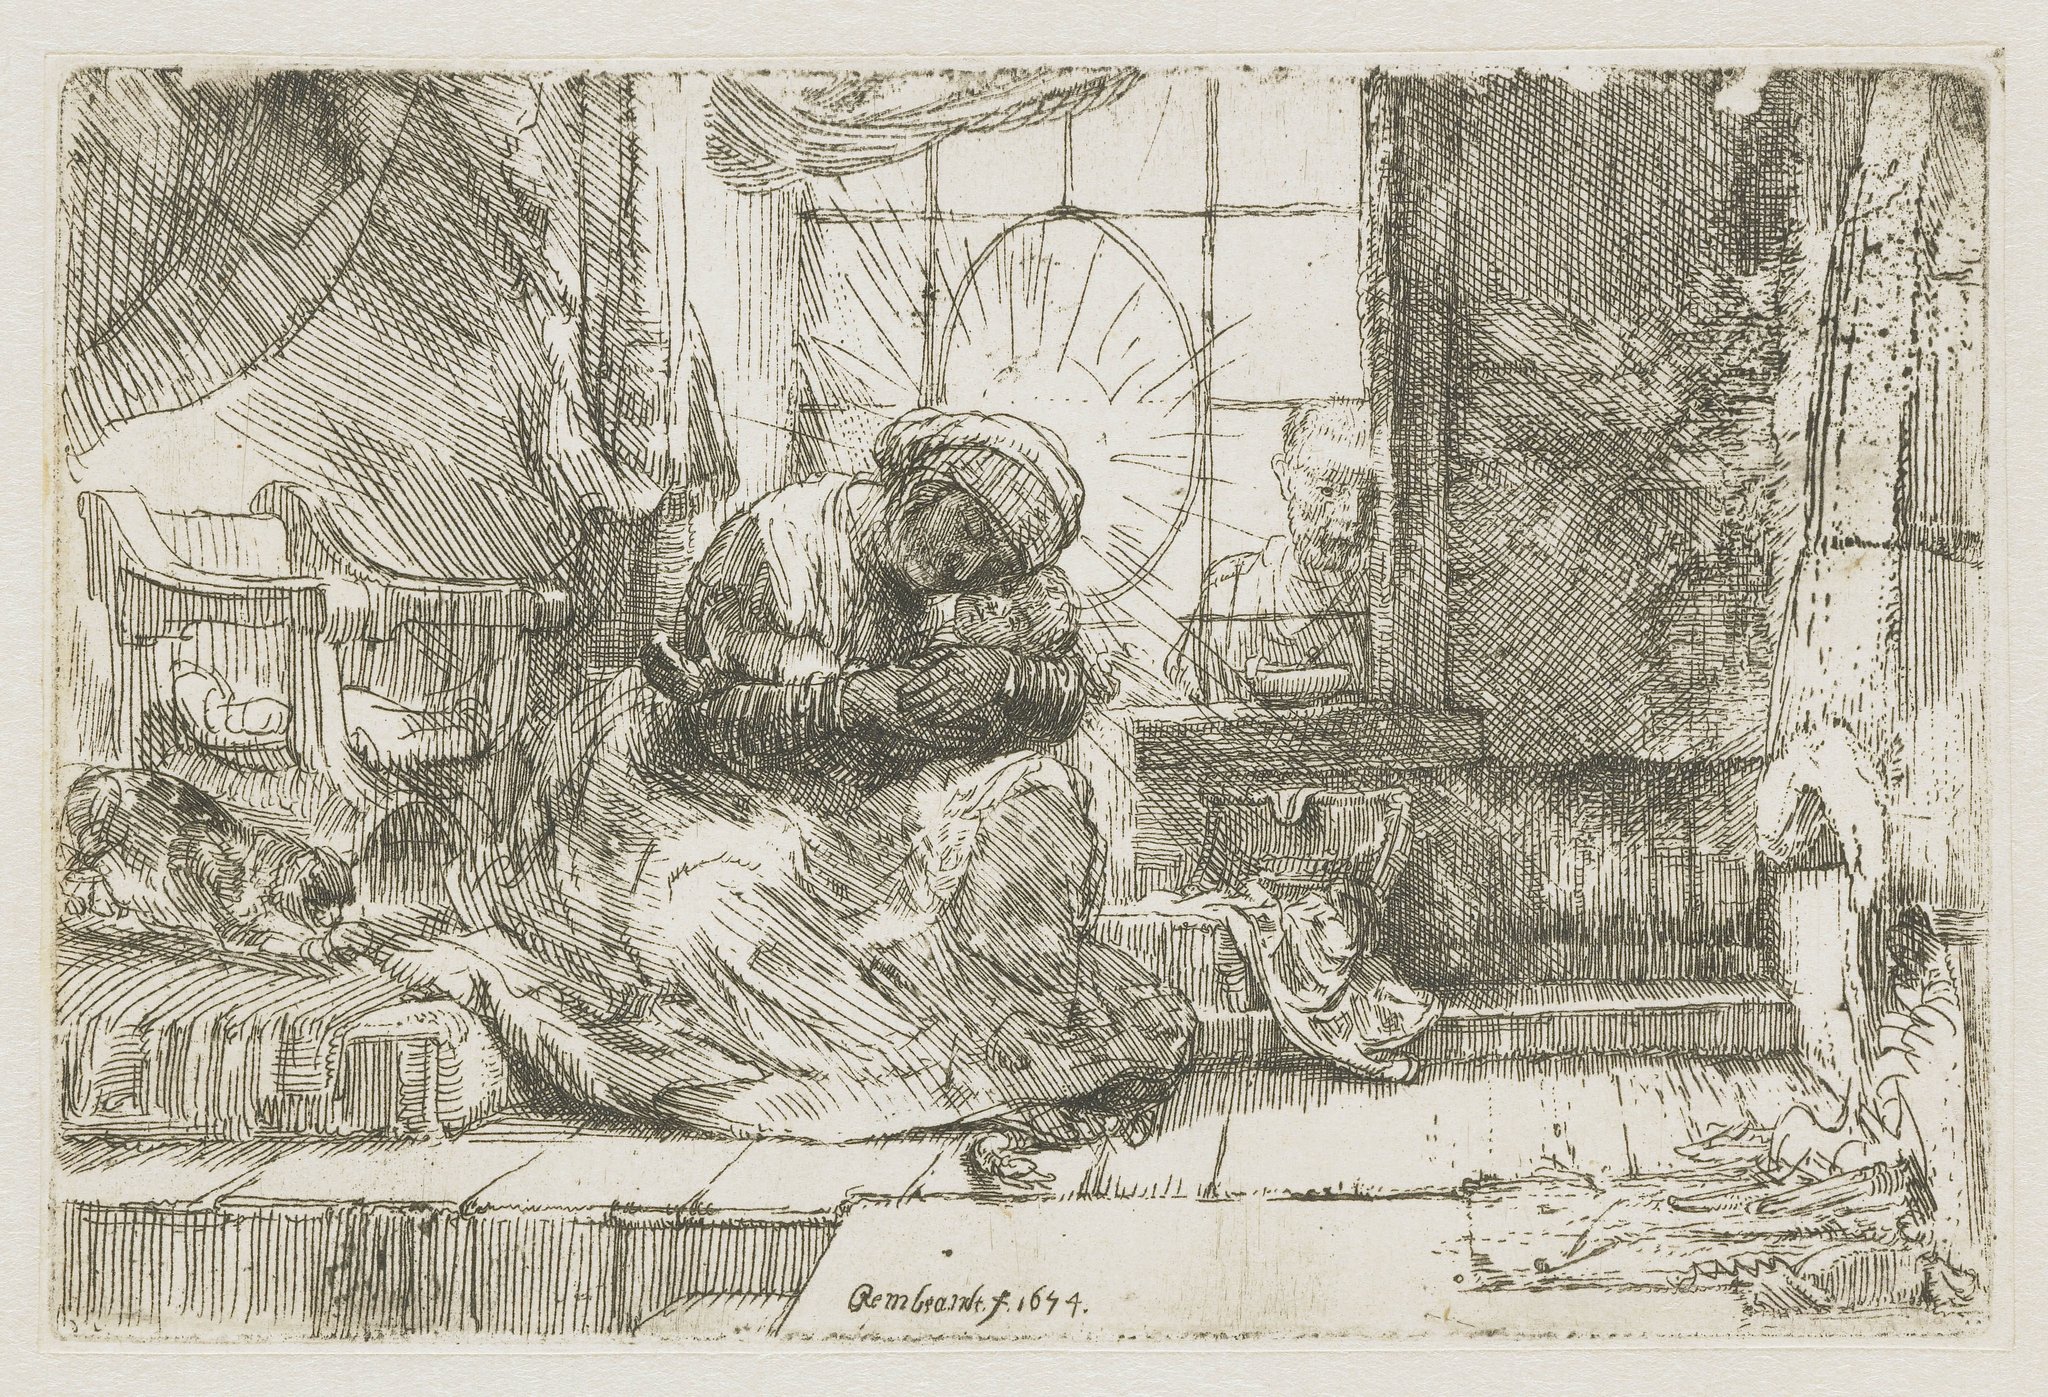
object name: print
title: The Virgin and Child with the cat and the snake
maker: rembrandt van rijn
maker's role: draughtsman, painter, print maker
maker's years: 1606-1669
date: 1654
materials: paper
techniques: etching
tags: madonna: mary sitting on the ground, the christ-child in her lap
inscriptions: collector's mark: Lugt 240, signature and date: ‘Rembrandt.f.1654’